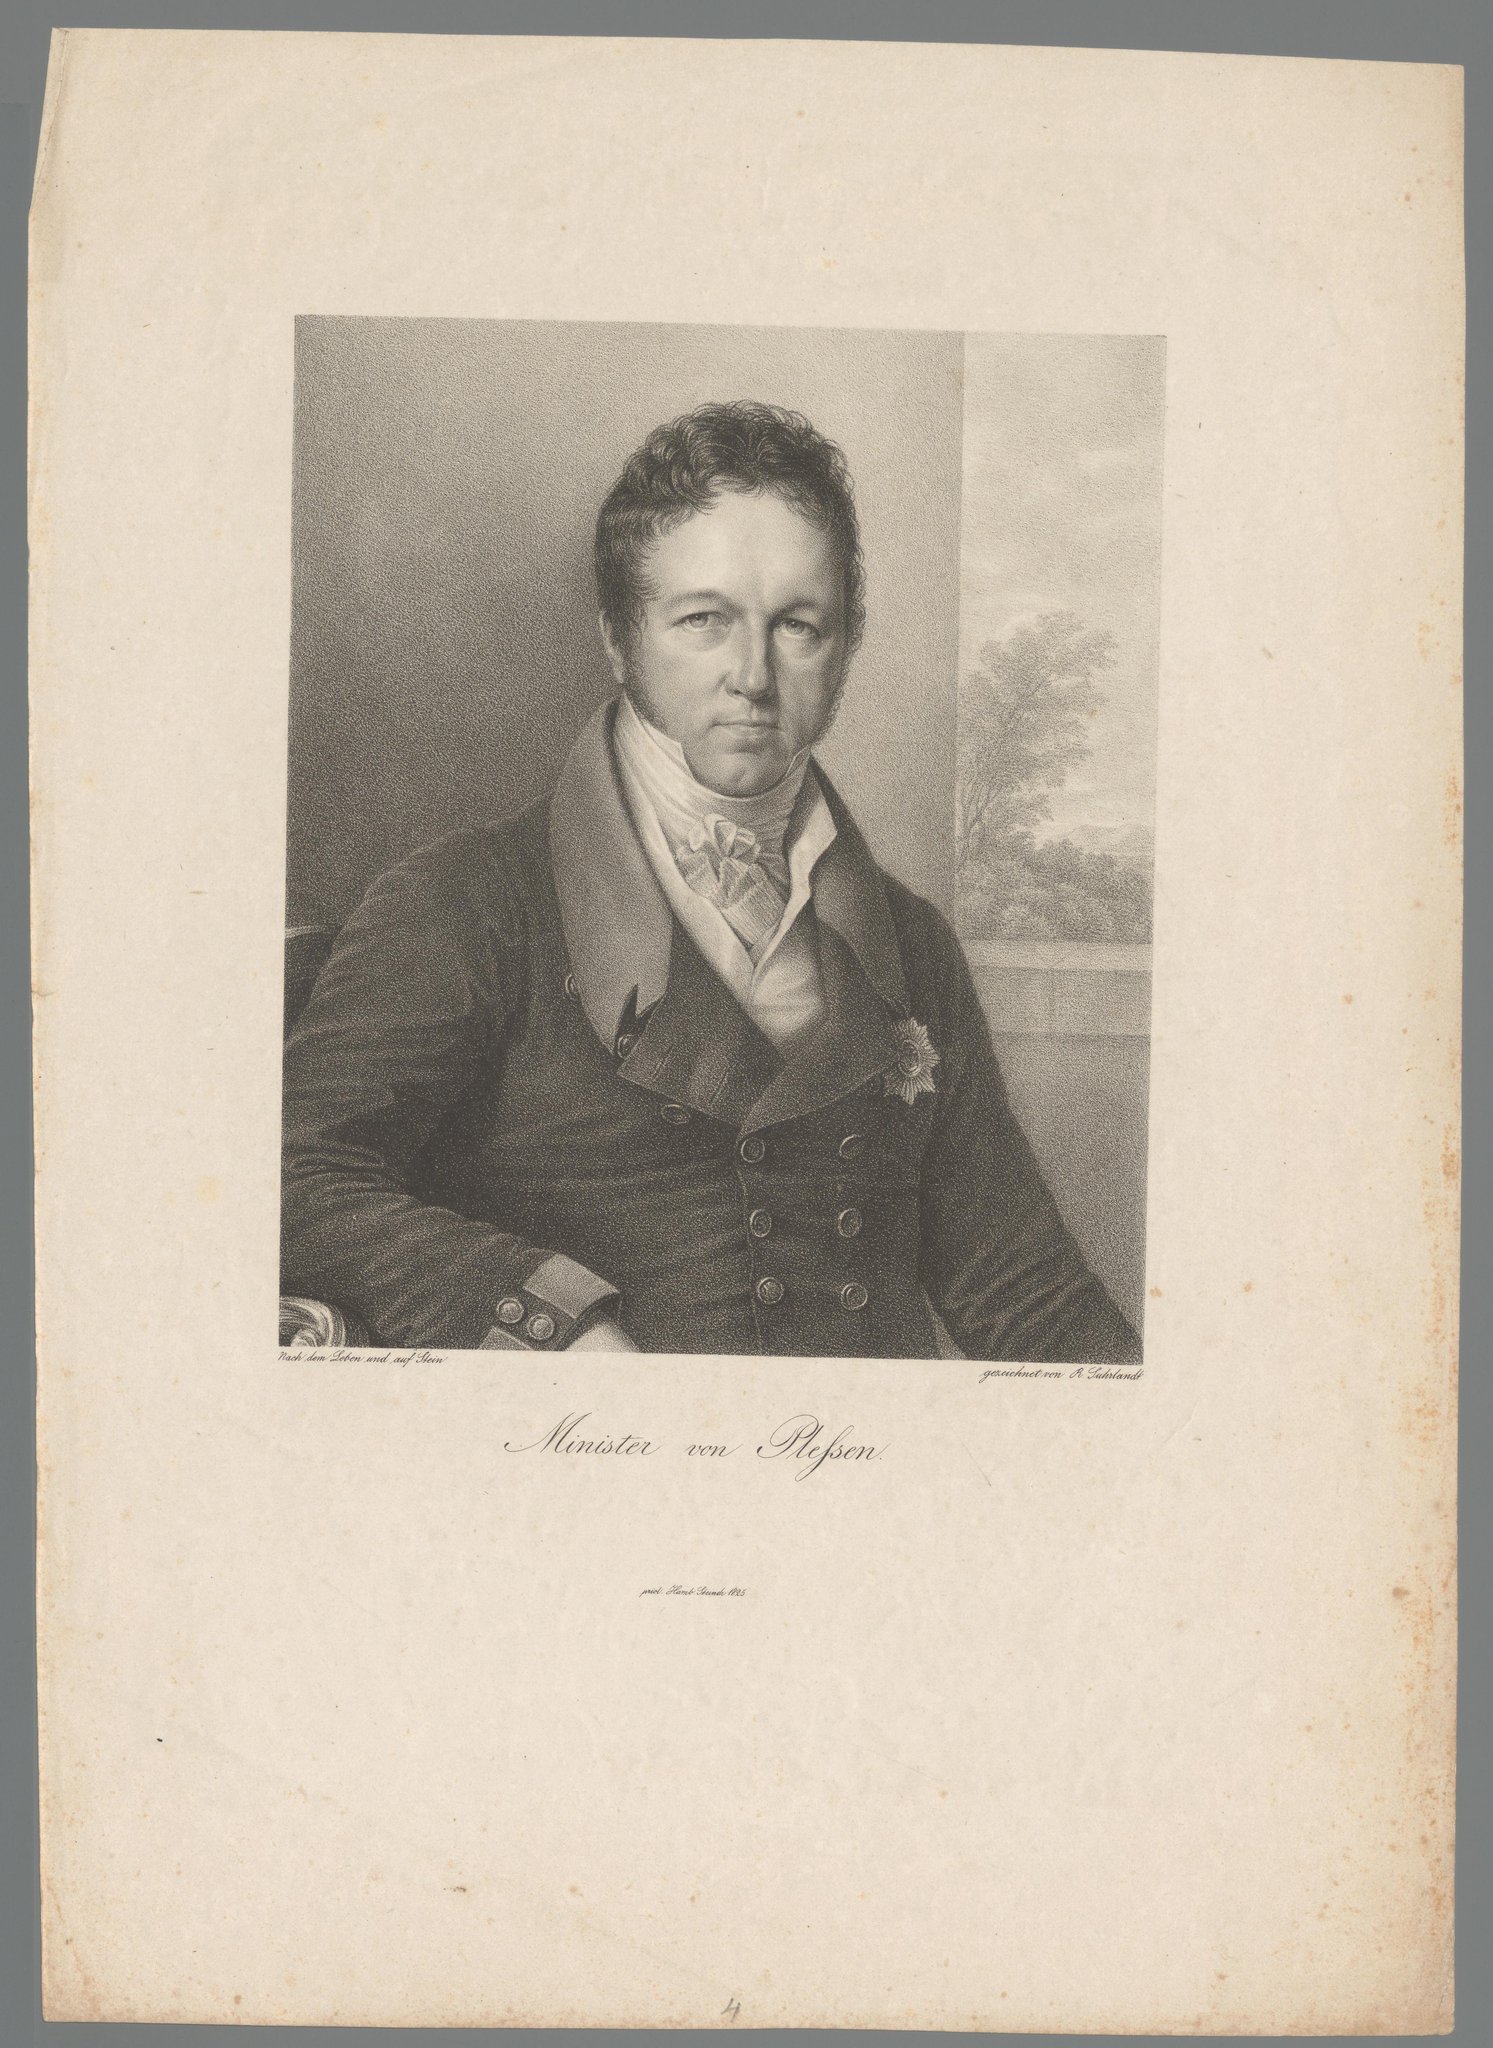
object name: print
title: Portret van Leopold von Plessen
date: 1825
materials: paper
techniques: lithograph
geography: hamburg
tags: adult man, historical persons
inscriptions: collector's mark: Lugt 2228